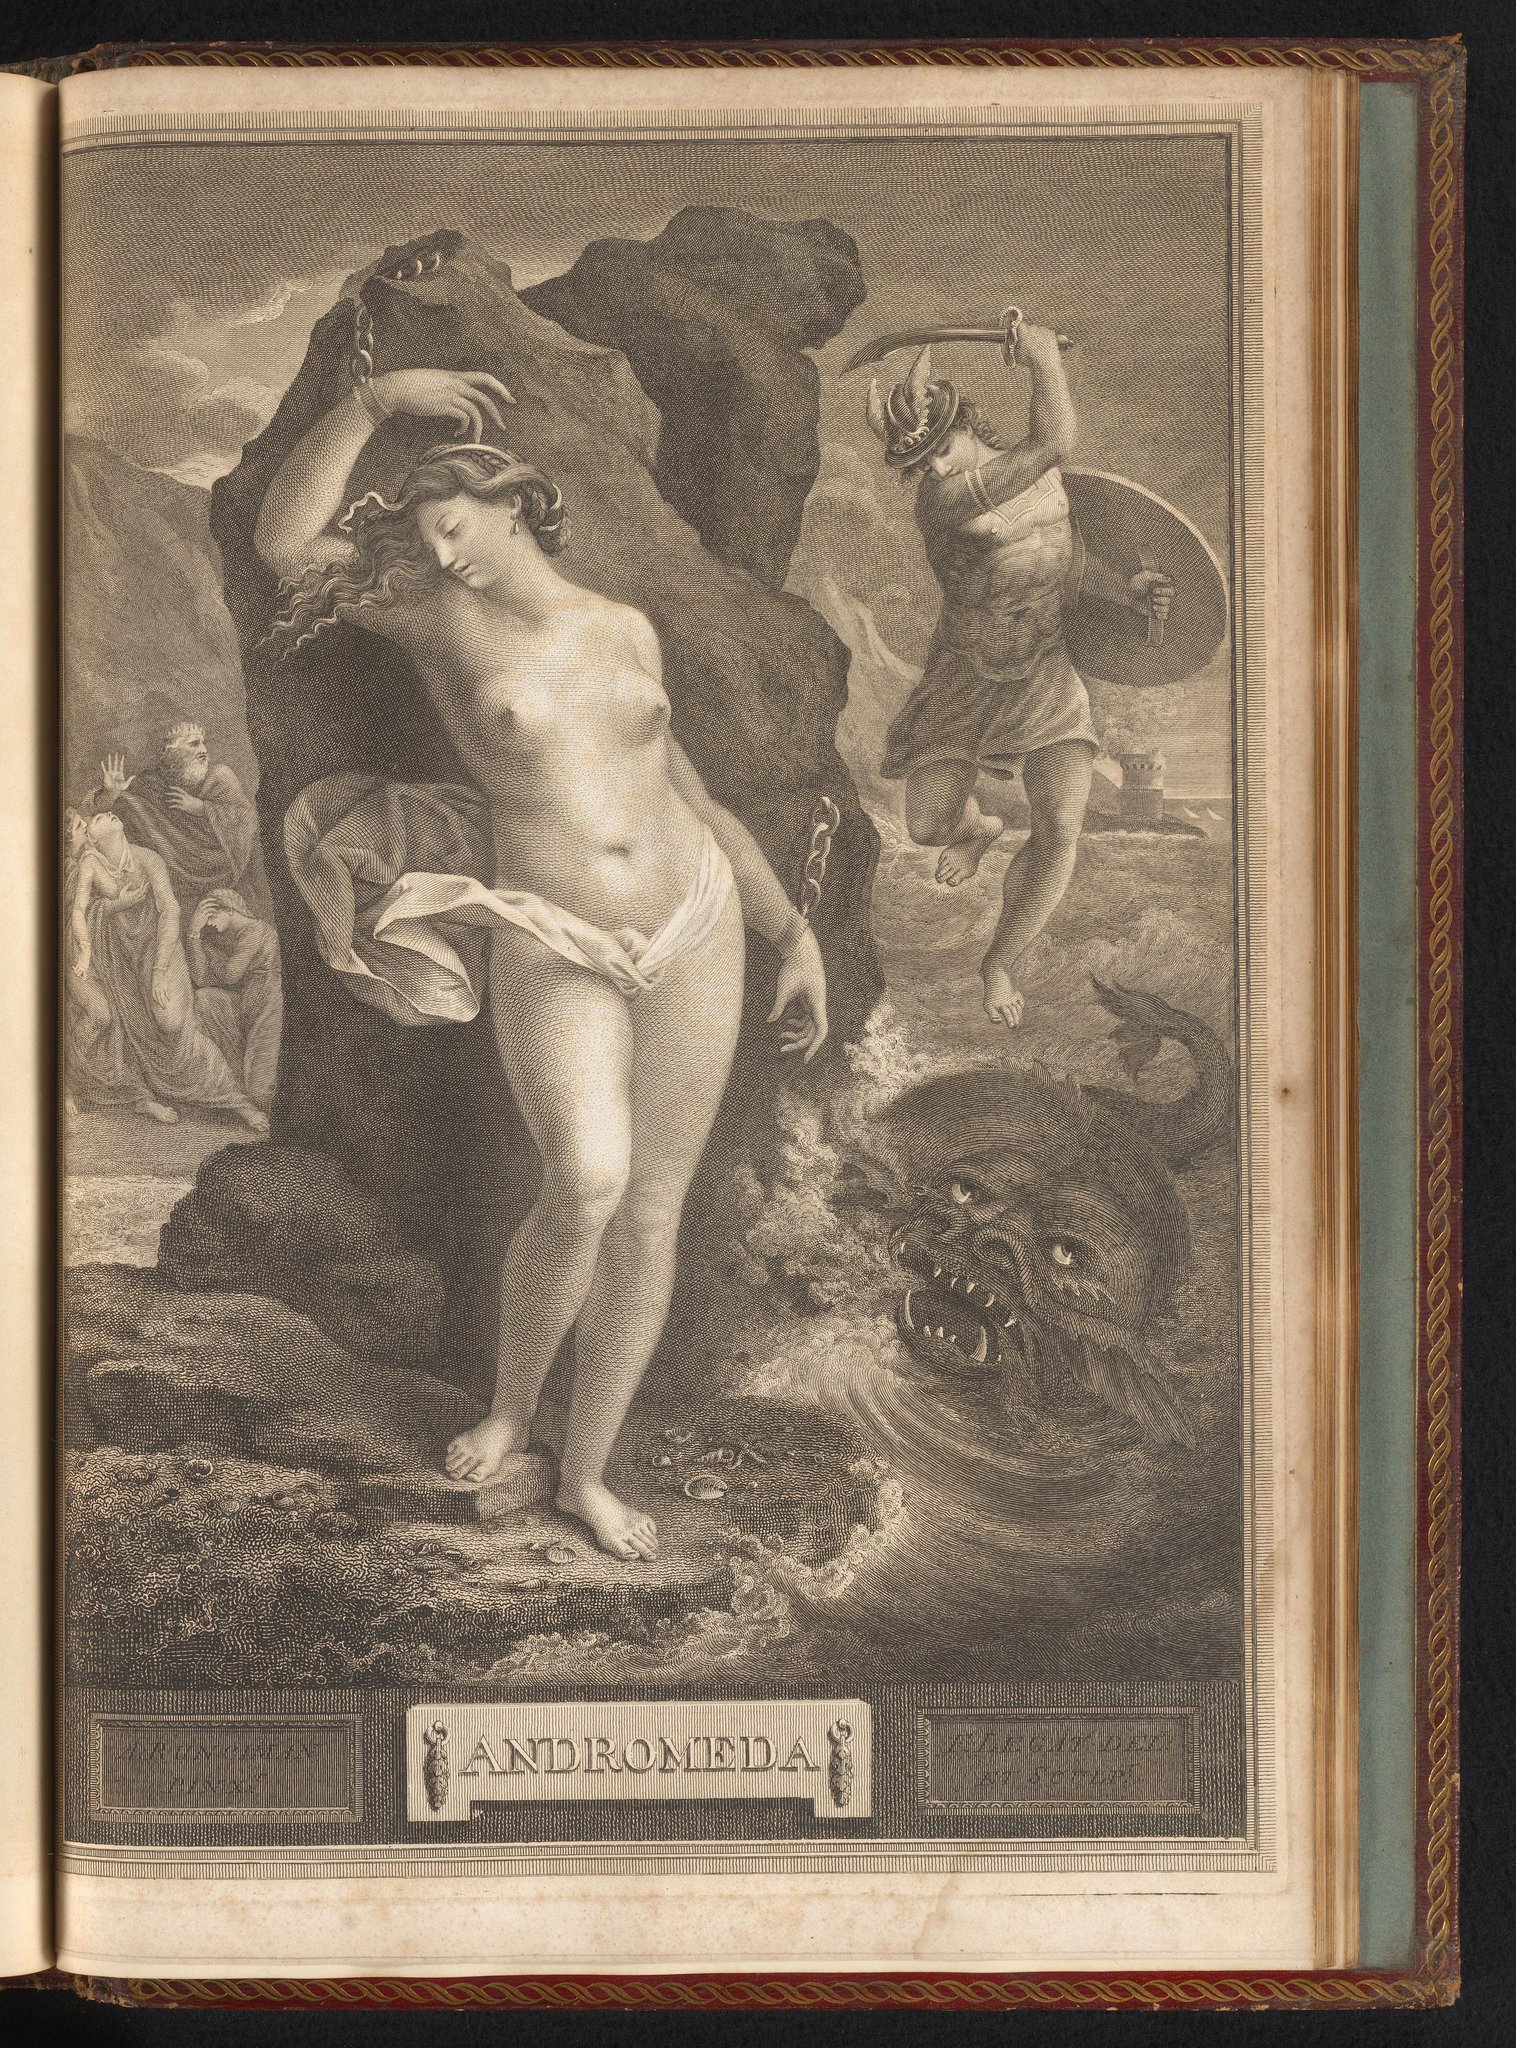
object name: album leaf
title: Andromeda en Perseus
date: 1771-1809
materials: paper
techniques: engraving, etching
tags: perseus and andromeda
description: De samensteller heeft deze prent in het album geplakt als illustratie bij: Pilkington, Matthew en Johann Heinrich Füssli. A dictionary of painters, from the revival of the art to the present period. 4 dln. Londen: John Crowder, 1805, dl. 4, p. 686.